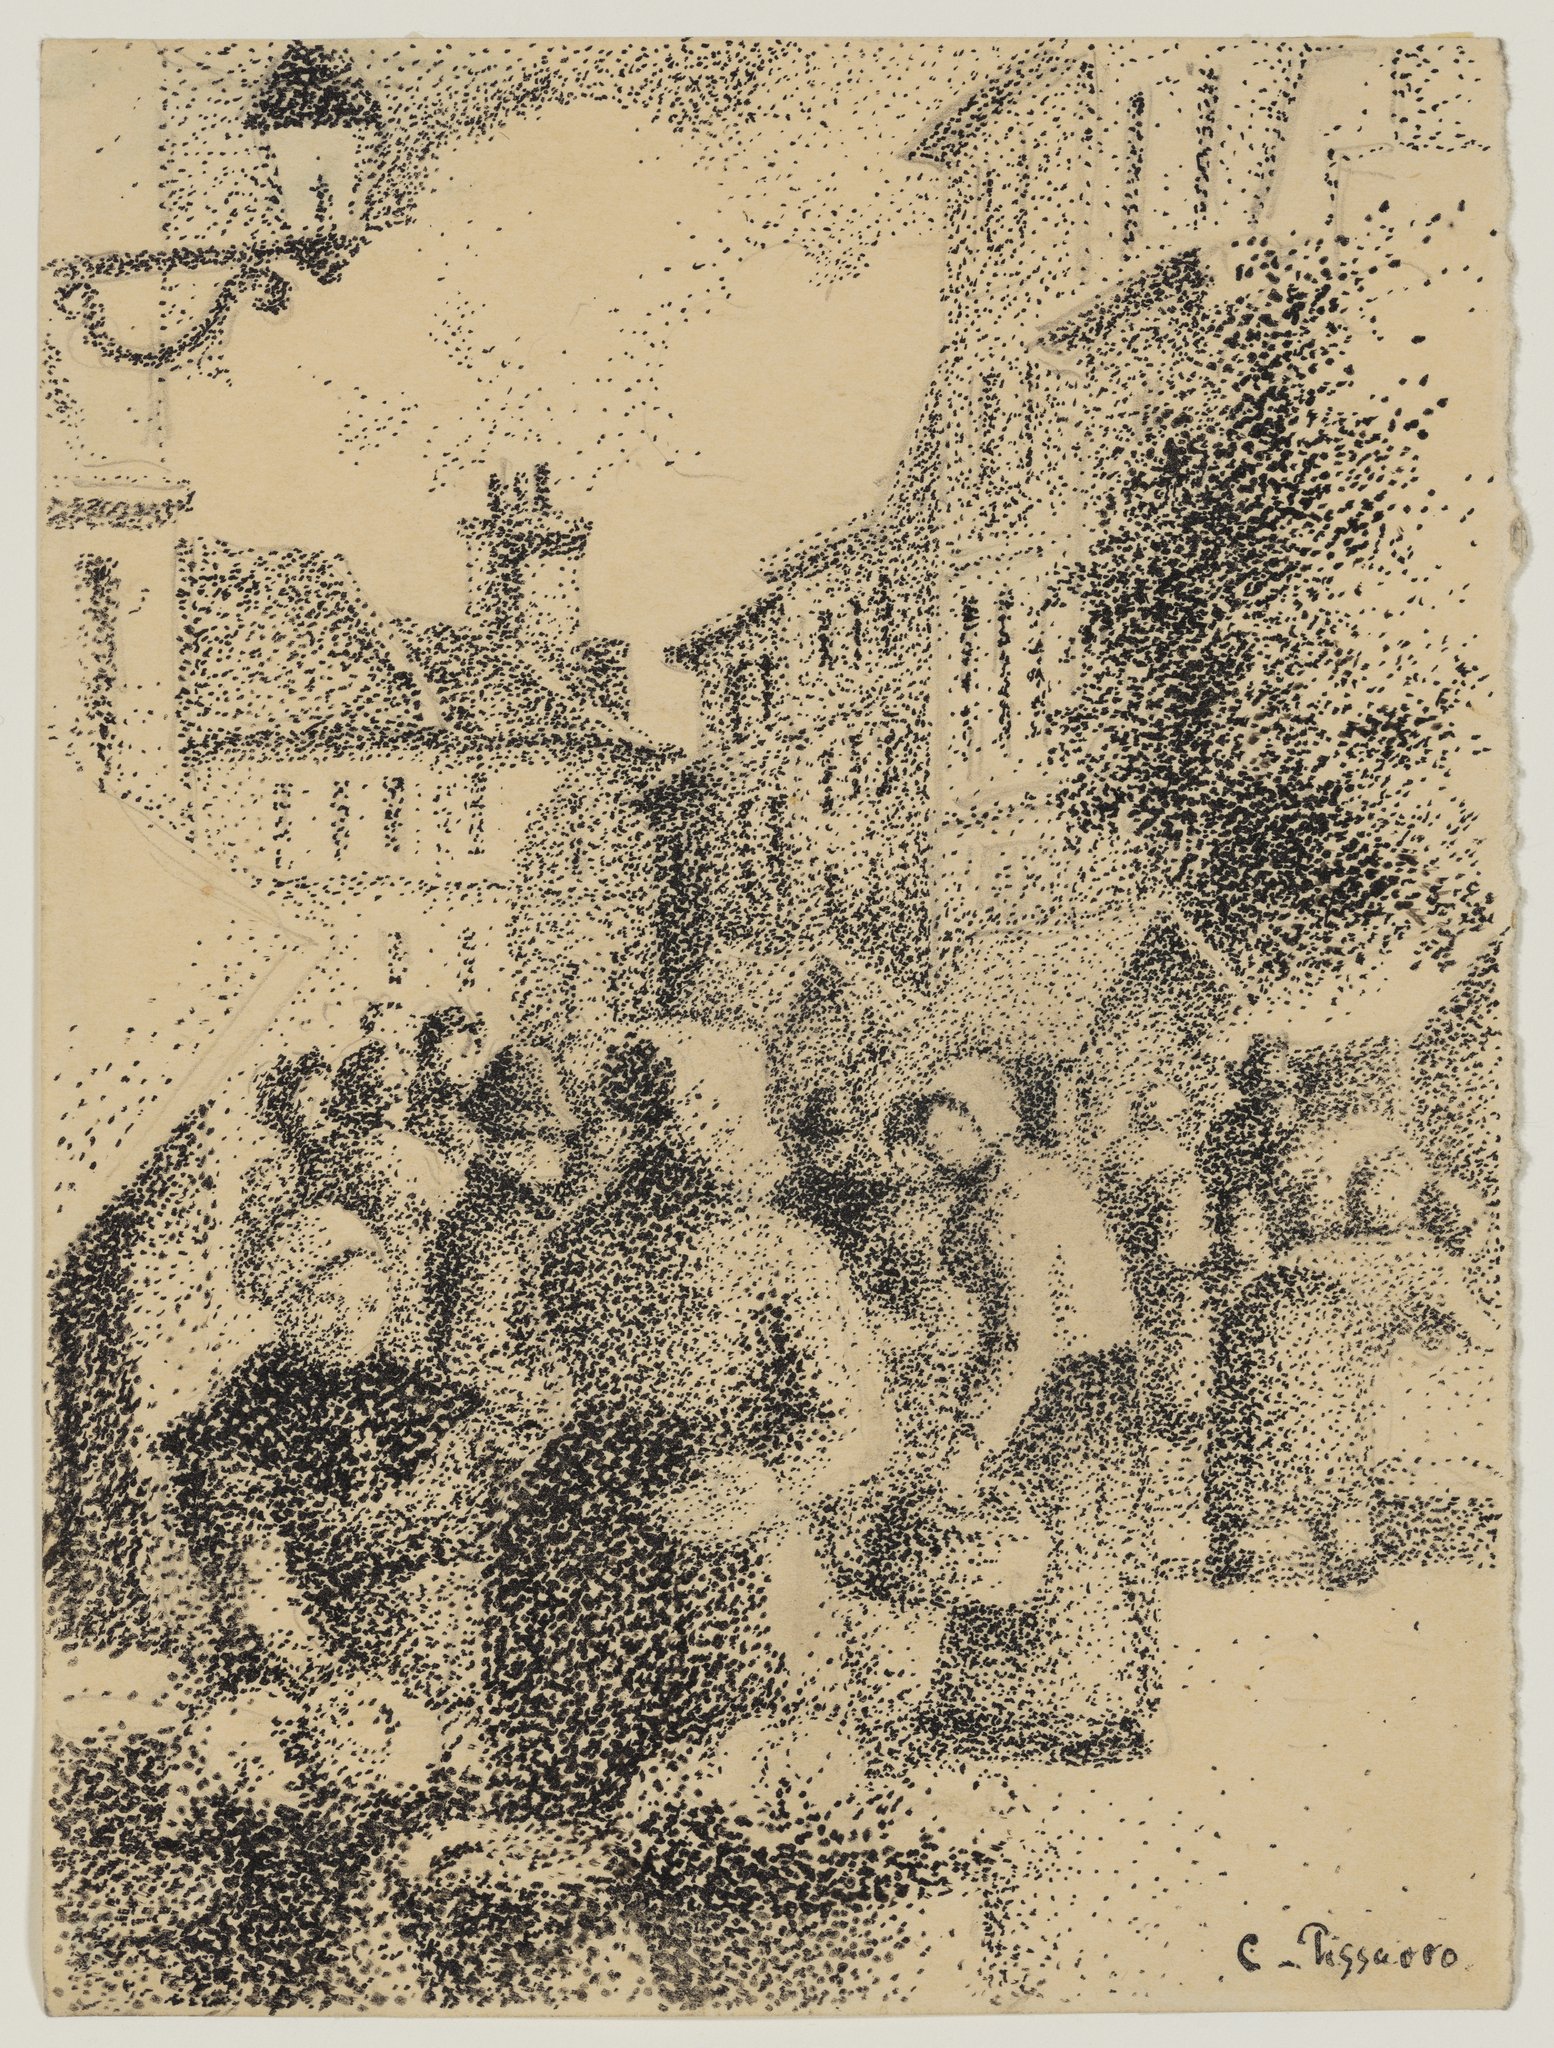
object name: drawing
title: Marketplace in Pontoise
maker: camille pissarro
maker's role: artist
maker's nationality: french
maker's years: 1830-1903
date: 1886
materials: graphite, ink, paper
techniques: pen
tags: markets